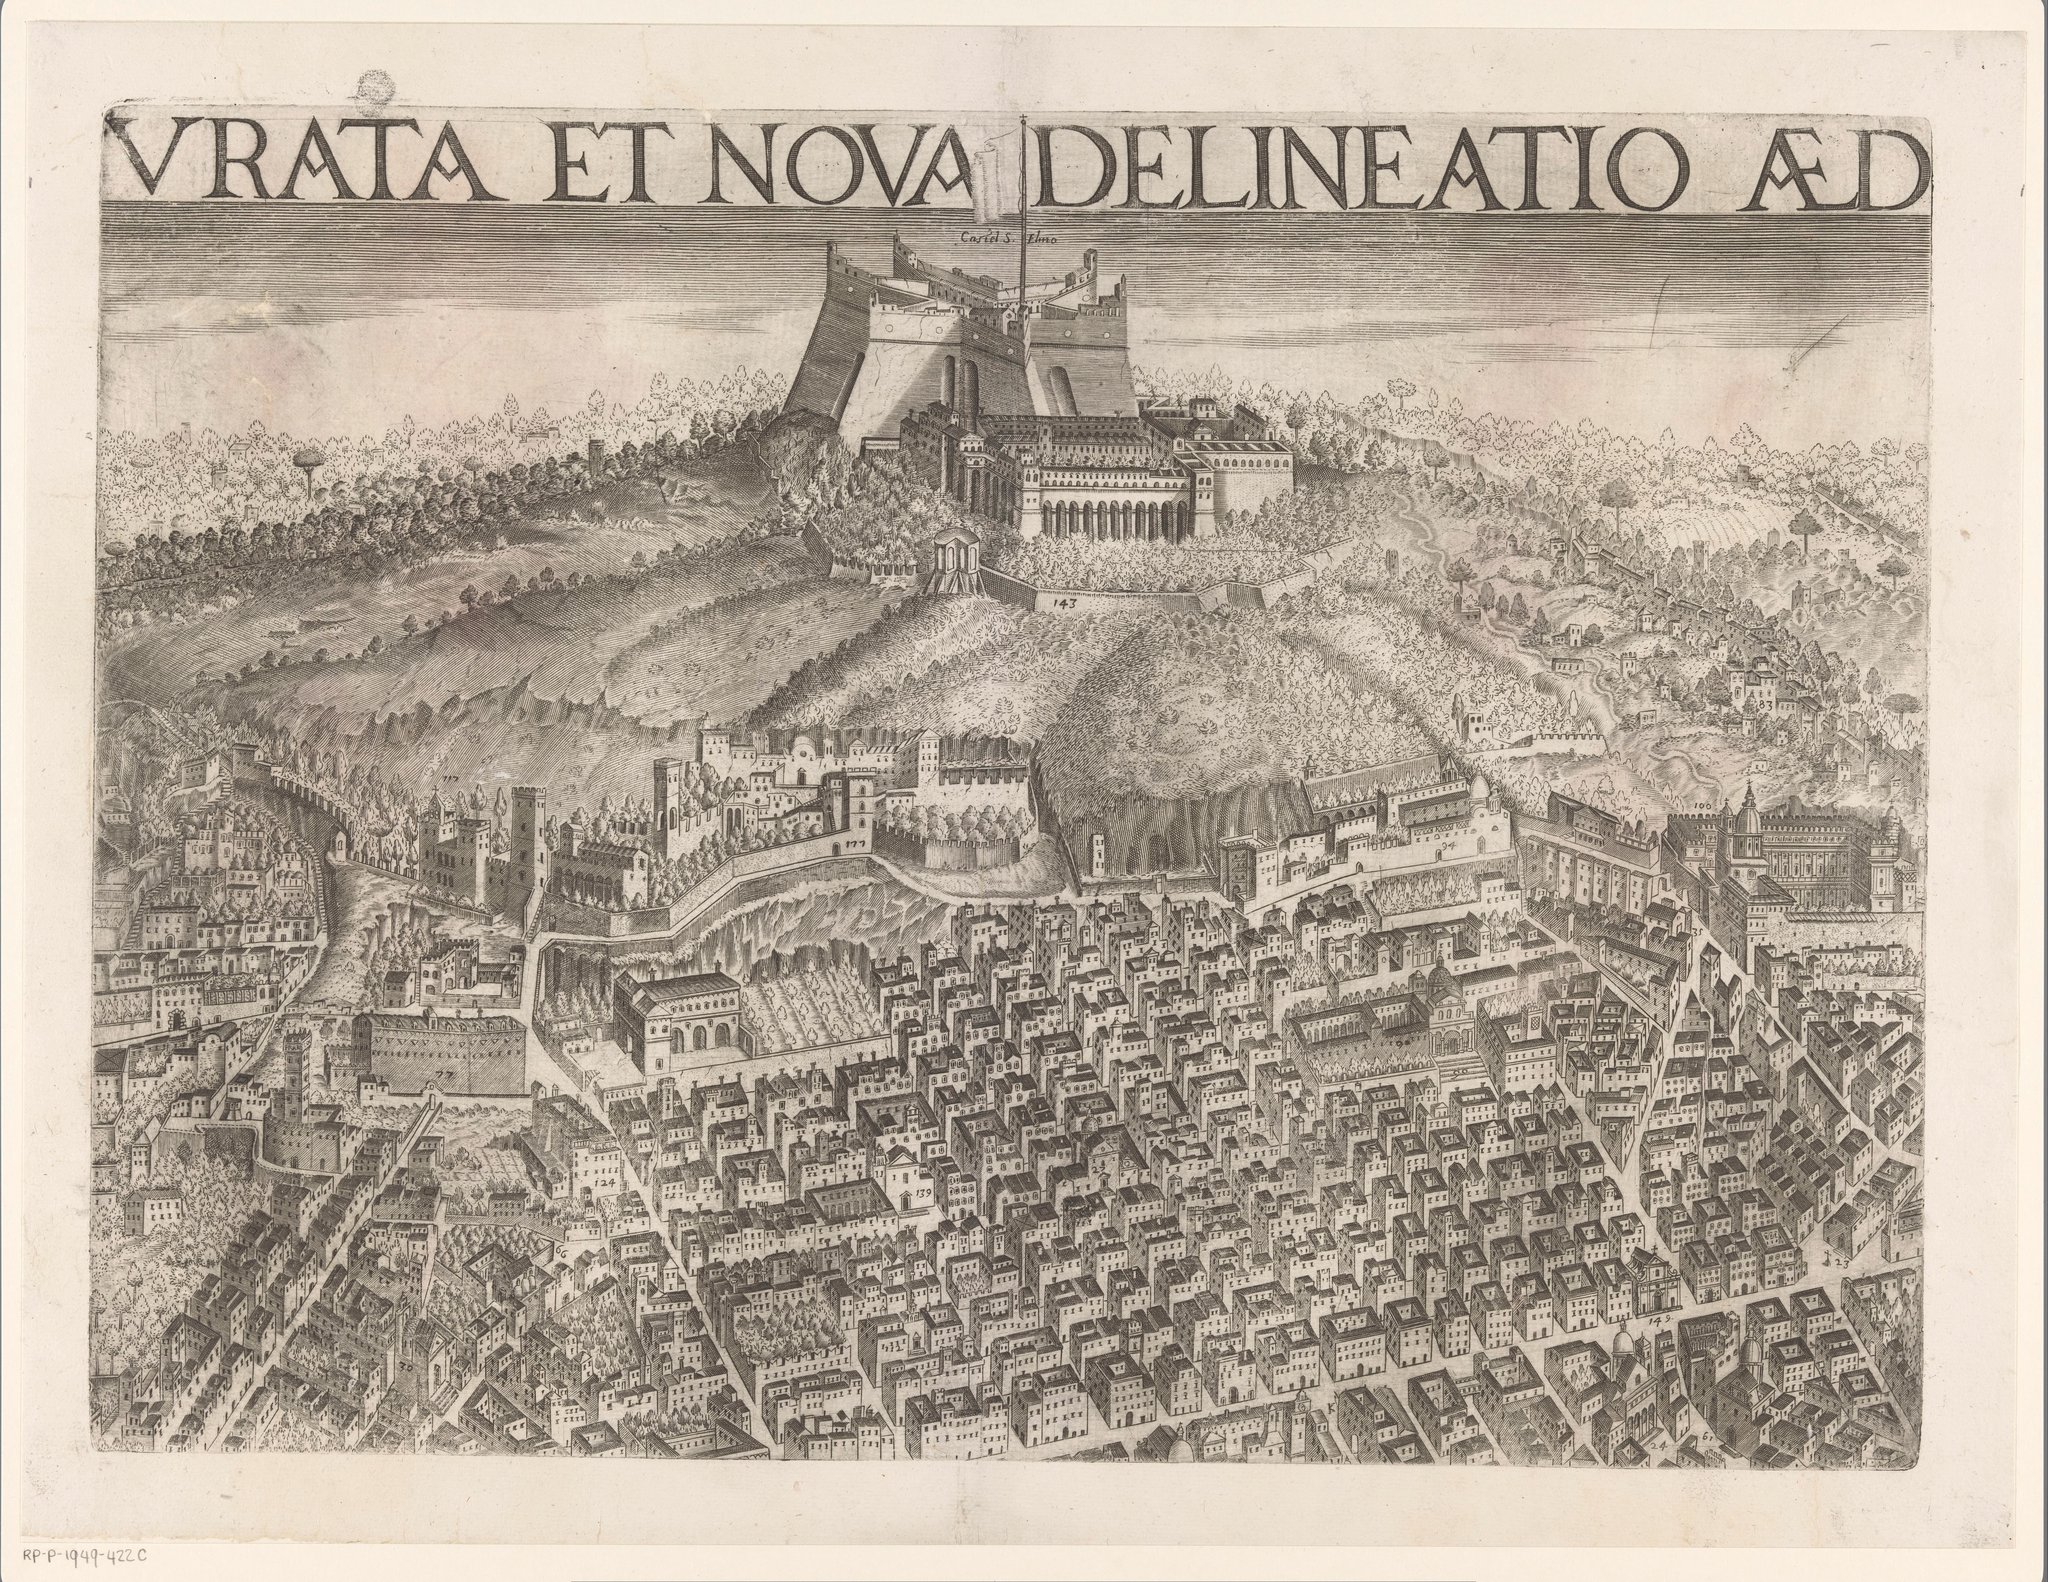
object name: print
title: Detail van een gezicht op Napels in vogelvluchtperspectief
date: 1629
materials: paper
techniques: engraving, etching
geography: naples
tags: city-view in general; 'veduta', castle, naples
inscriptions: collector's mark: Lugt 2228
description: Deze prent maakt onderdeel uit van een gezicht op Napels in vogelvluchtperspectief. De gehele voorstelling wordt gevormd door zestien prenten. Hiervan bevinden zich zes prenten in de collectie van het Rijksmuseum.